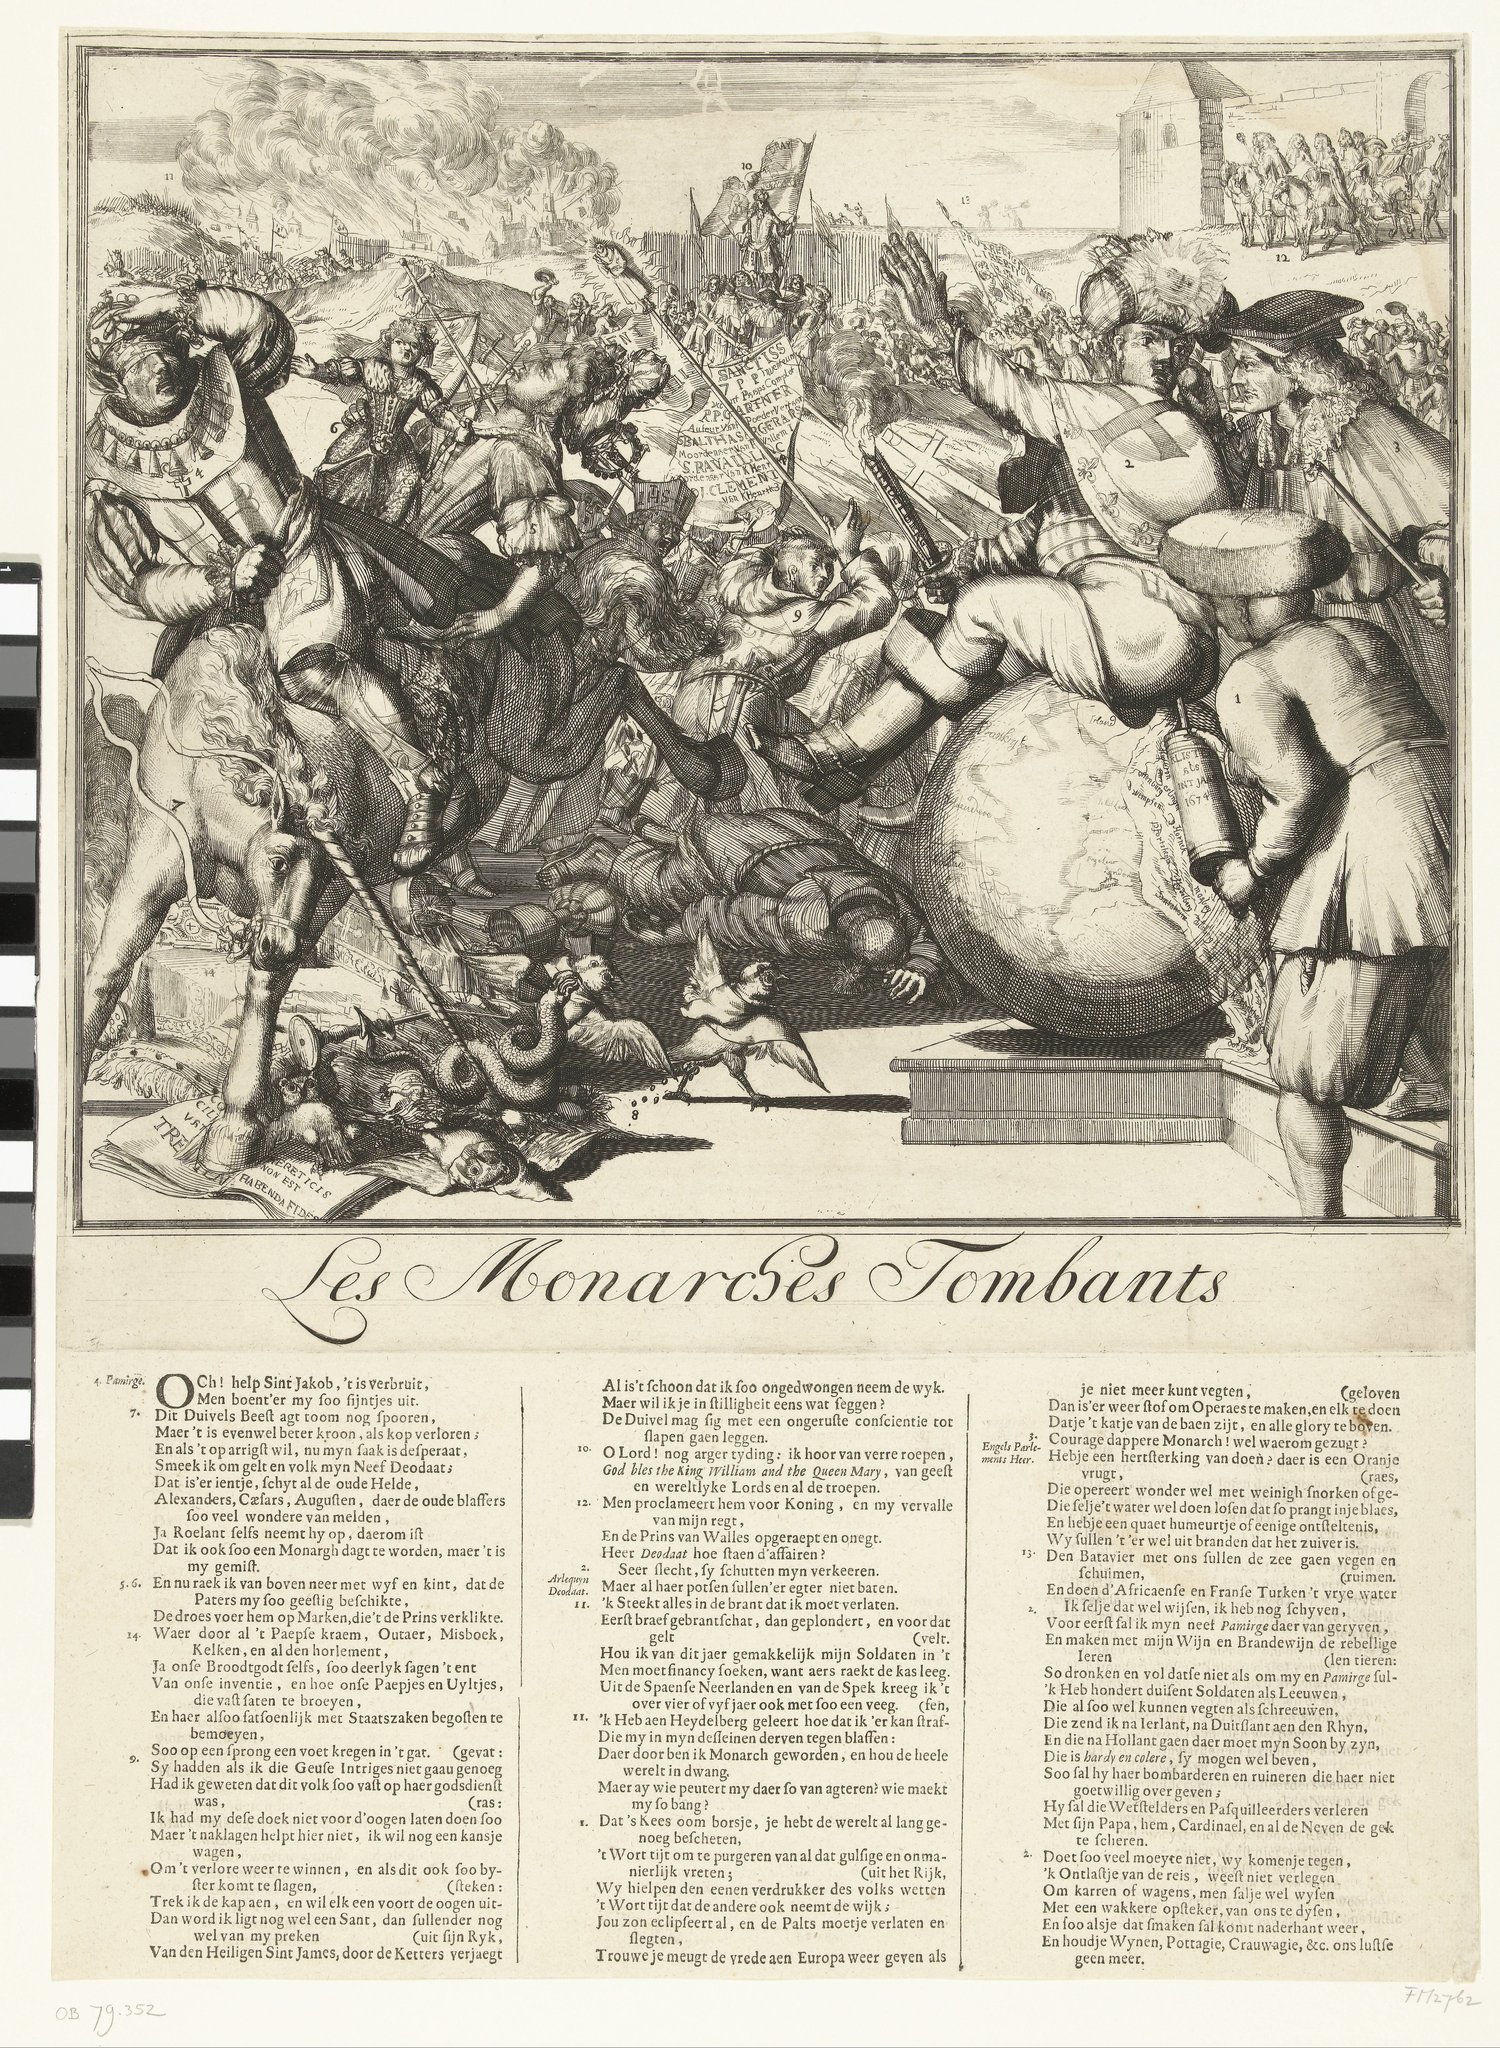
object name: print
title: The Falling Monarchs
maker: romeyn de hooghe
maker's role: draughtsman, goldsmith, painter, print maker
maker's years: 1645-1708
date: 1689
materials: paper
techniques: engraving, etching, letterpress printing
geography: northern netherlands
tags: jacobus ii (koning van engeland en schotland), lodewijk xiv (koning van frankrijk), paris, london, rome, purging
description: The Glorious Revolution of Dutch Stadtholder William III caused panic among Catholic rulers. The English unicorn bucks King James II and his wife and child from its back. Louis XIV may still be sitting on top of the world, but a Dutch sailor is injecting a clyster spout into the French monarch’s bottom, containing an enema to make him poop out everything his greed has gobbled up.